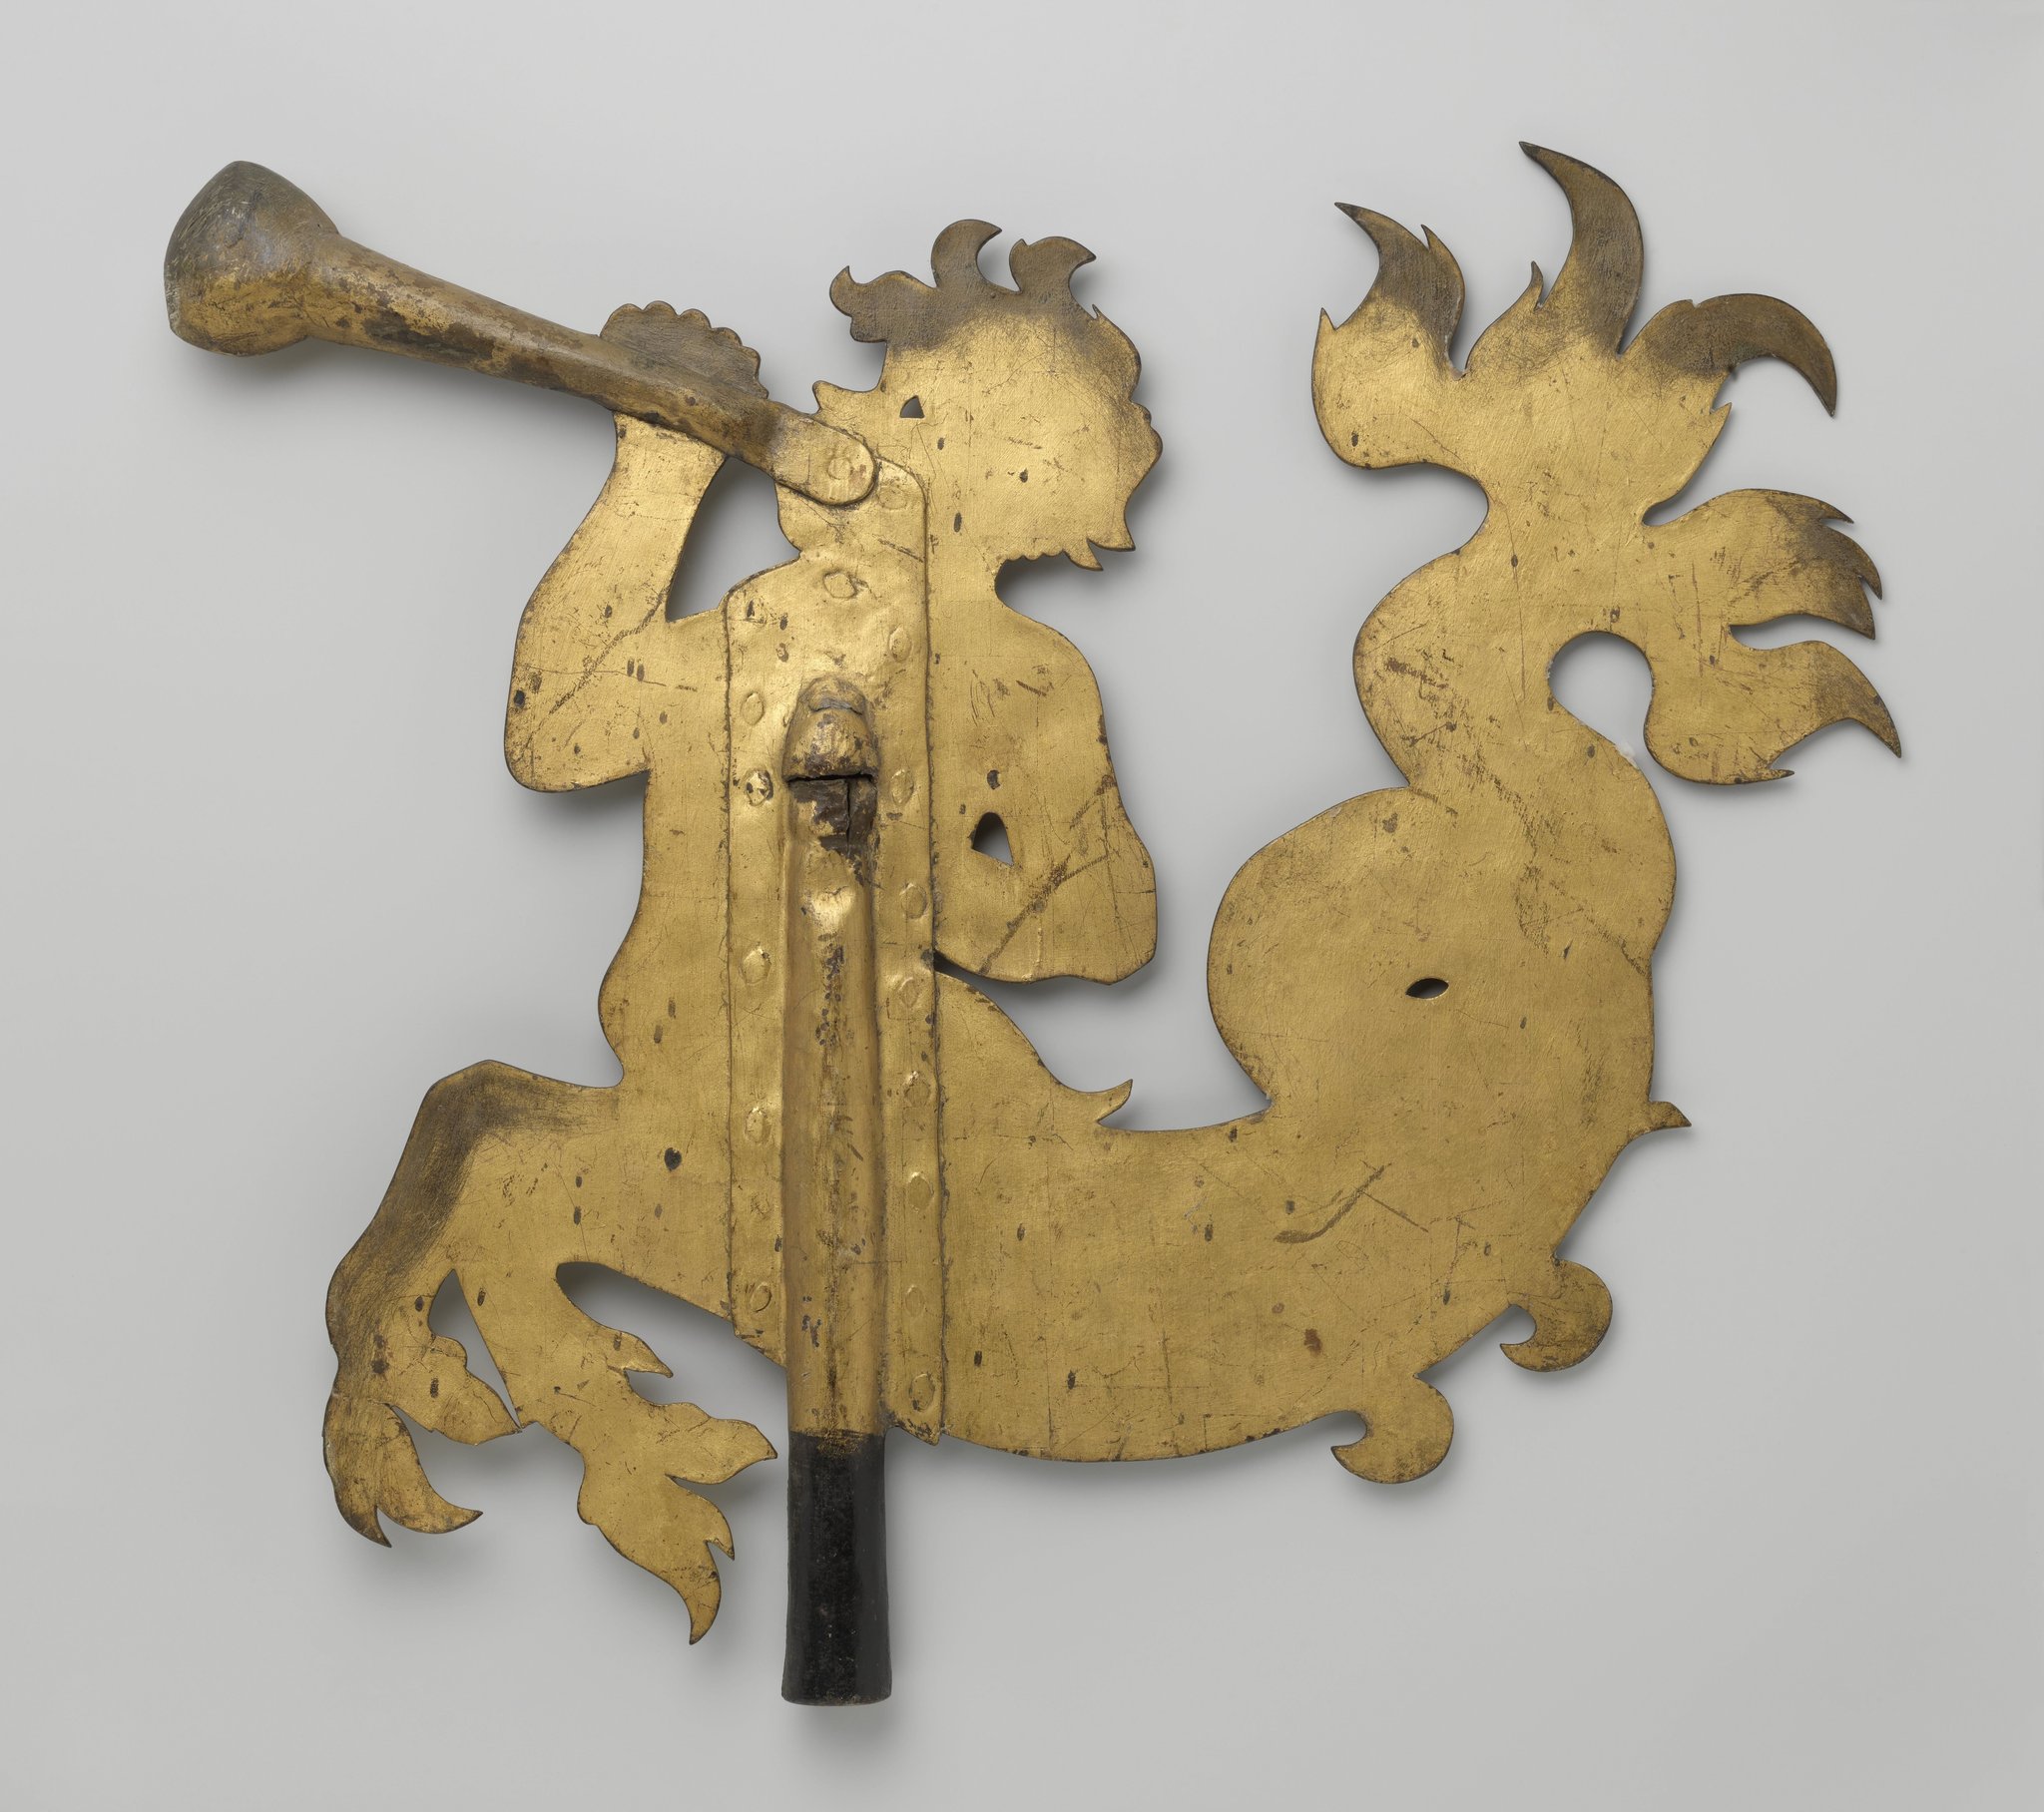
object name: weather vane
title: Windvaan van koper, met triton, afkomstig van de Hogewoerdspoort te Leiden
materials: copper, iron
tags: hogewoerdspoort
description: Een koperen windvaan met bol, een triton, afkomstig van de Hogewoerdspoort te Leiden. De ijzeren spil eindigende in 4 lippen.